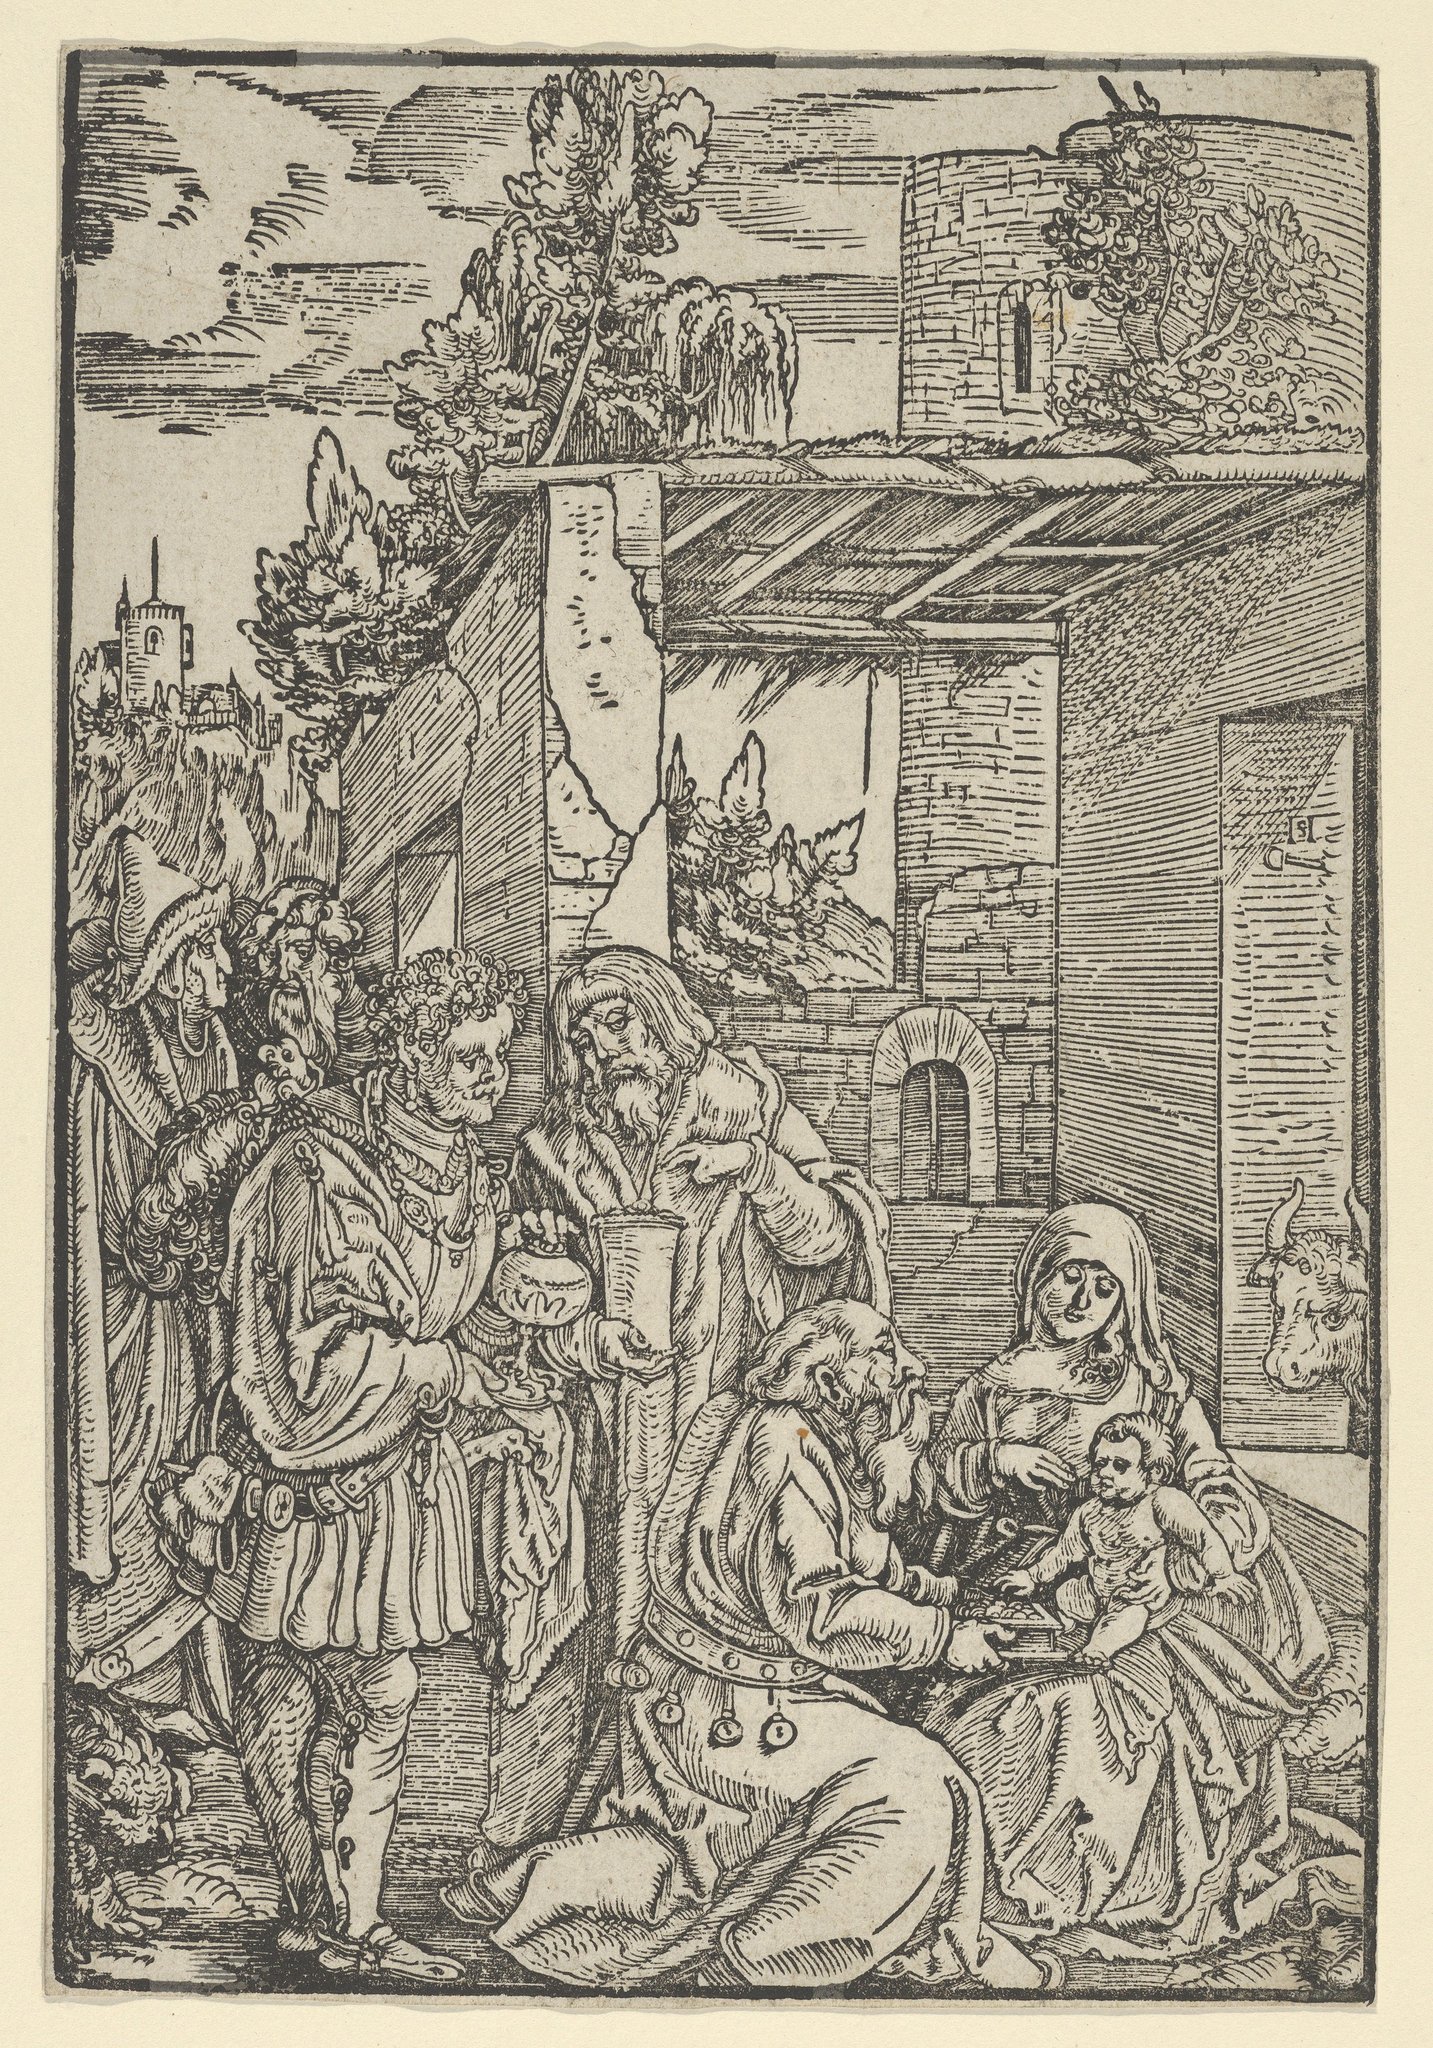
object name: print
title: The Adoration of the Magi, from Ewangeli und Epistel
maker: hans schäufelein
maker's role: artist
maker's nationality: german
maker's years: 1480-1540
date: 1512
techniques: woodcut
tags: men,madonna and child,adoration of the magi